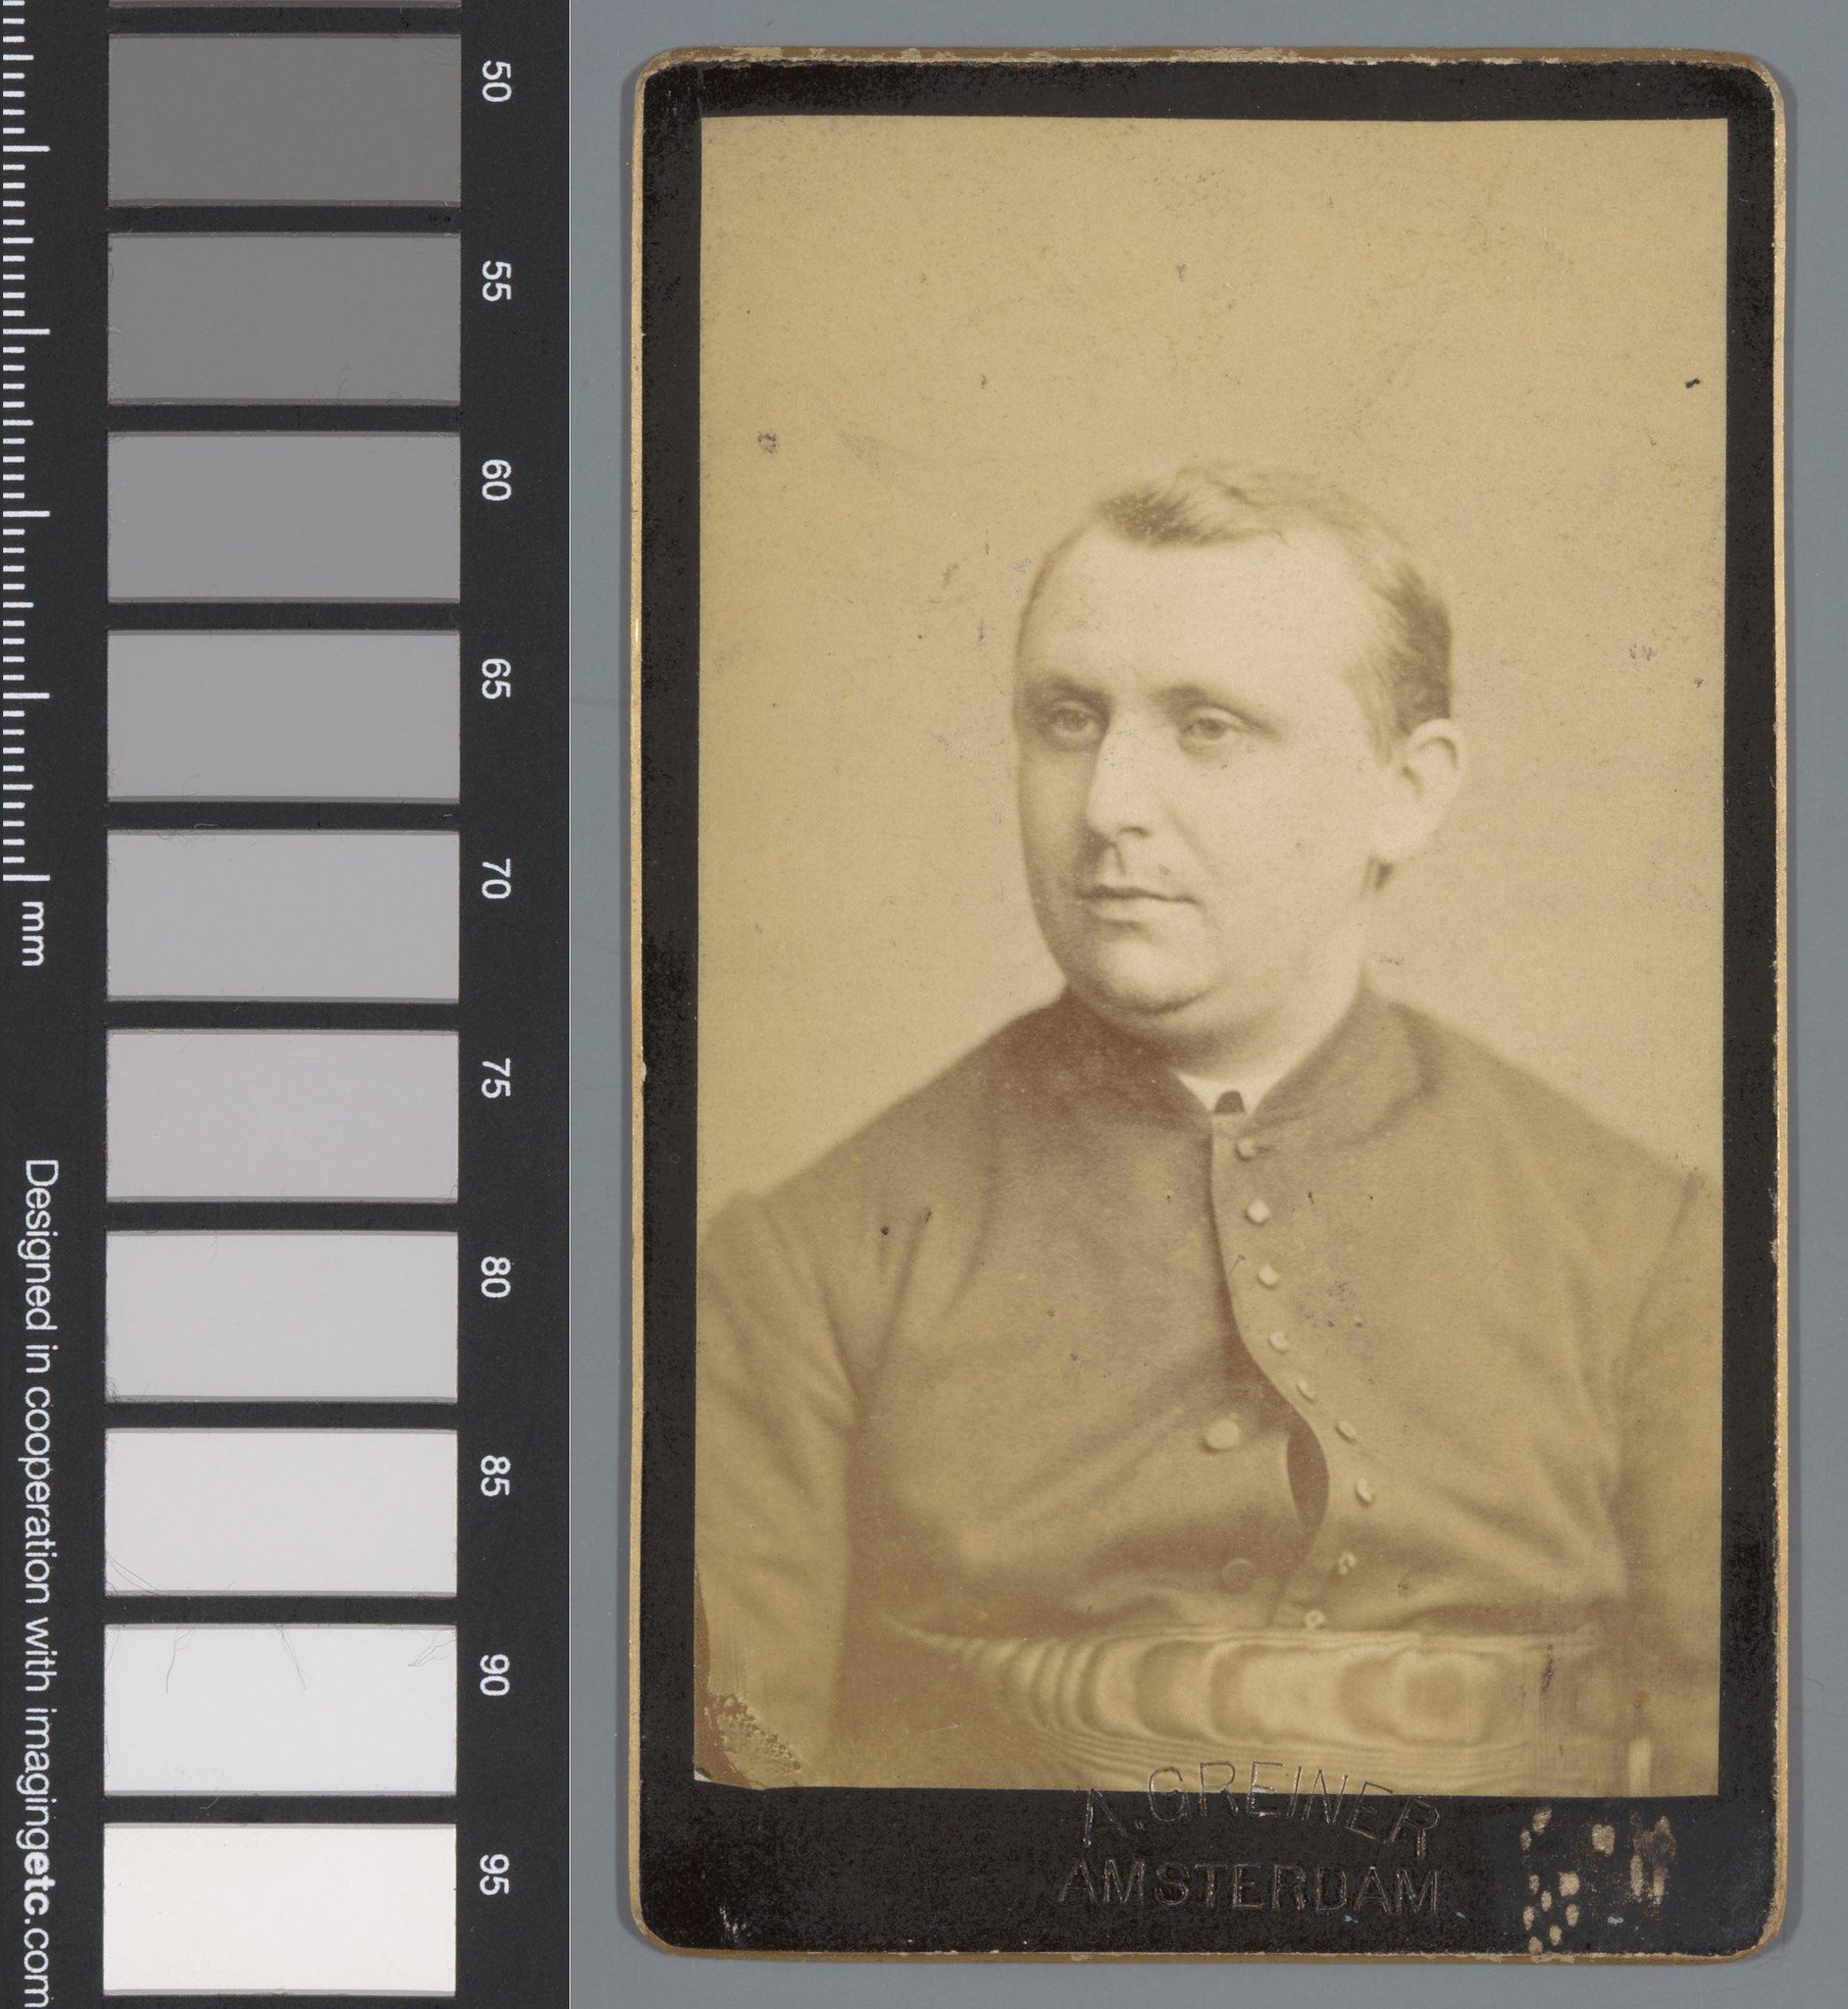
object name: carte de visite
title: Portret van een onbekende man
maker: albert greiner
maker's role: fotograaf, fotostudio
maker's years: 1833-1890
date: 1861-1890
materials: cardboard, paper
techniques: albumen print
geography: amsterdam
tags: adult man, historical persons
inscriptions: inscription: ‘A. GREINER/ AMSTERDAM’